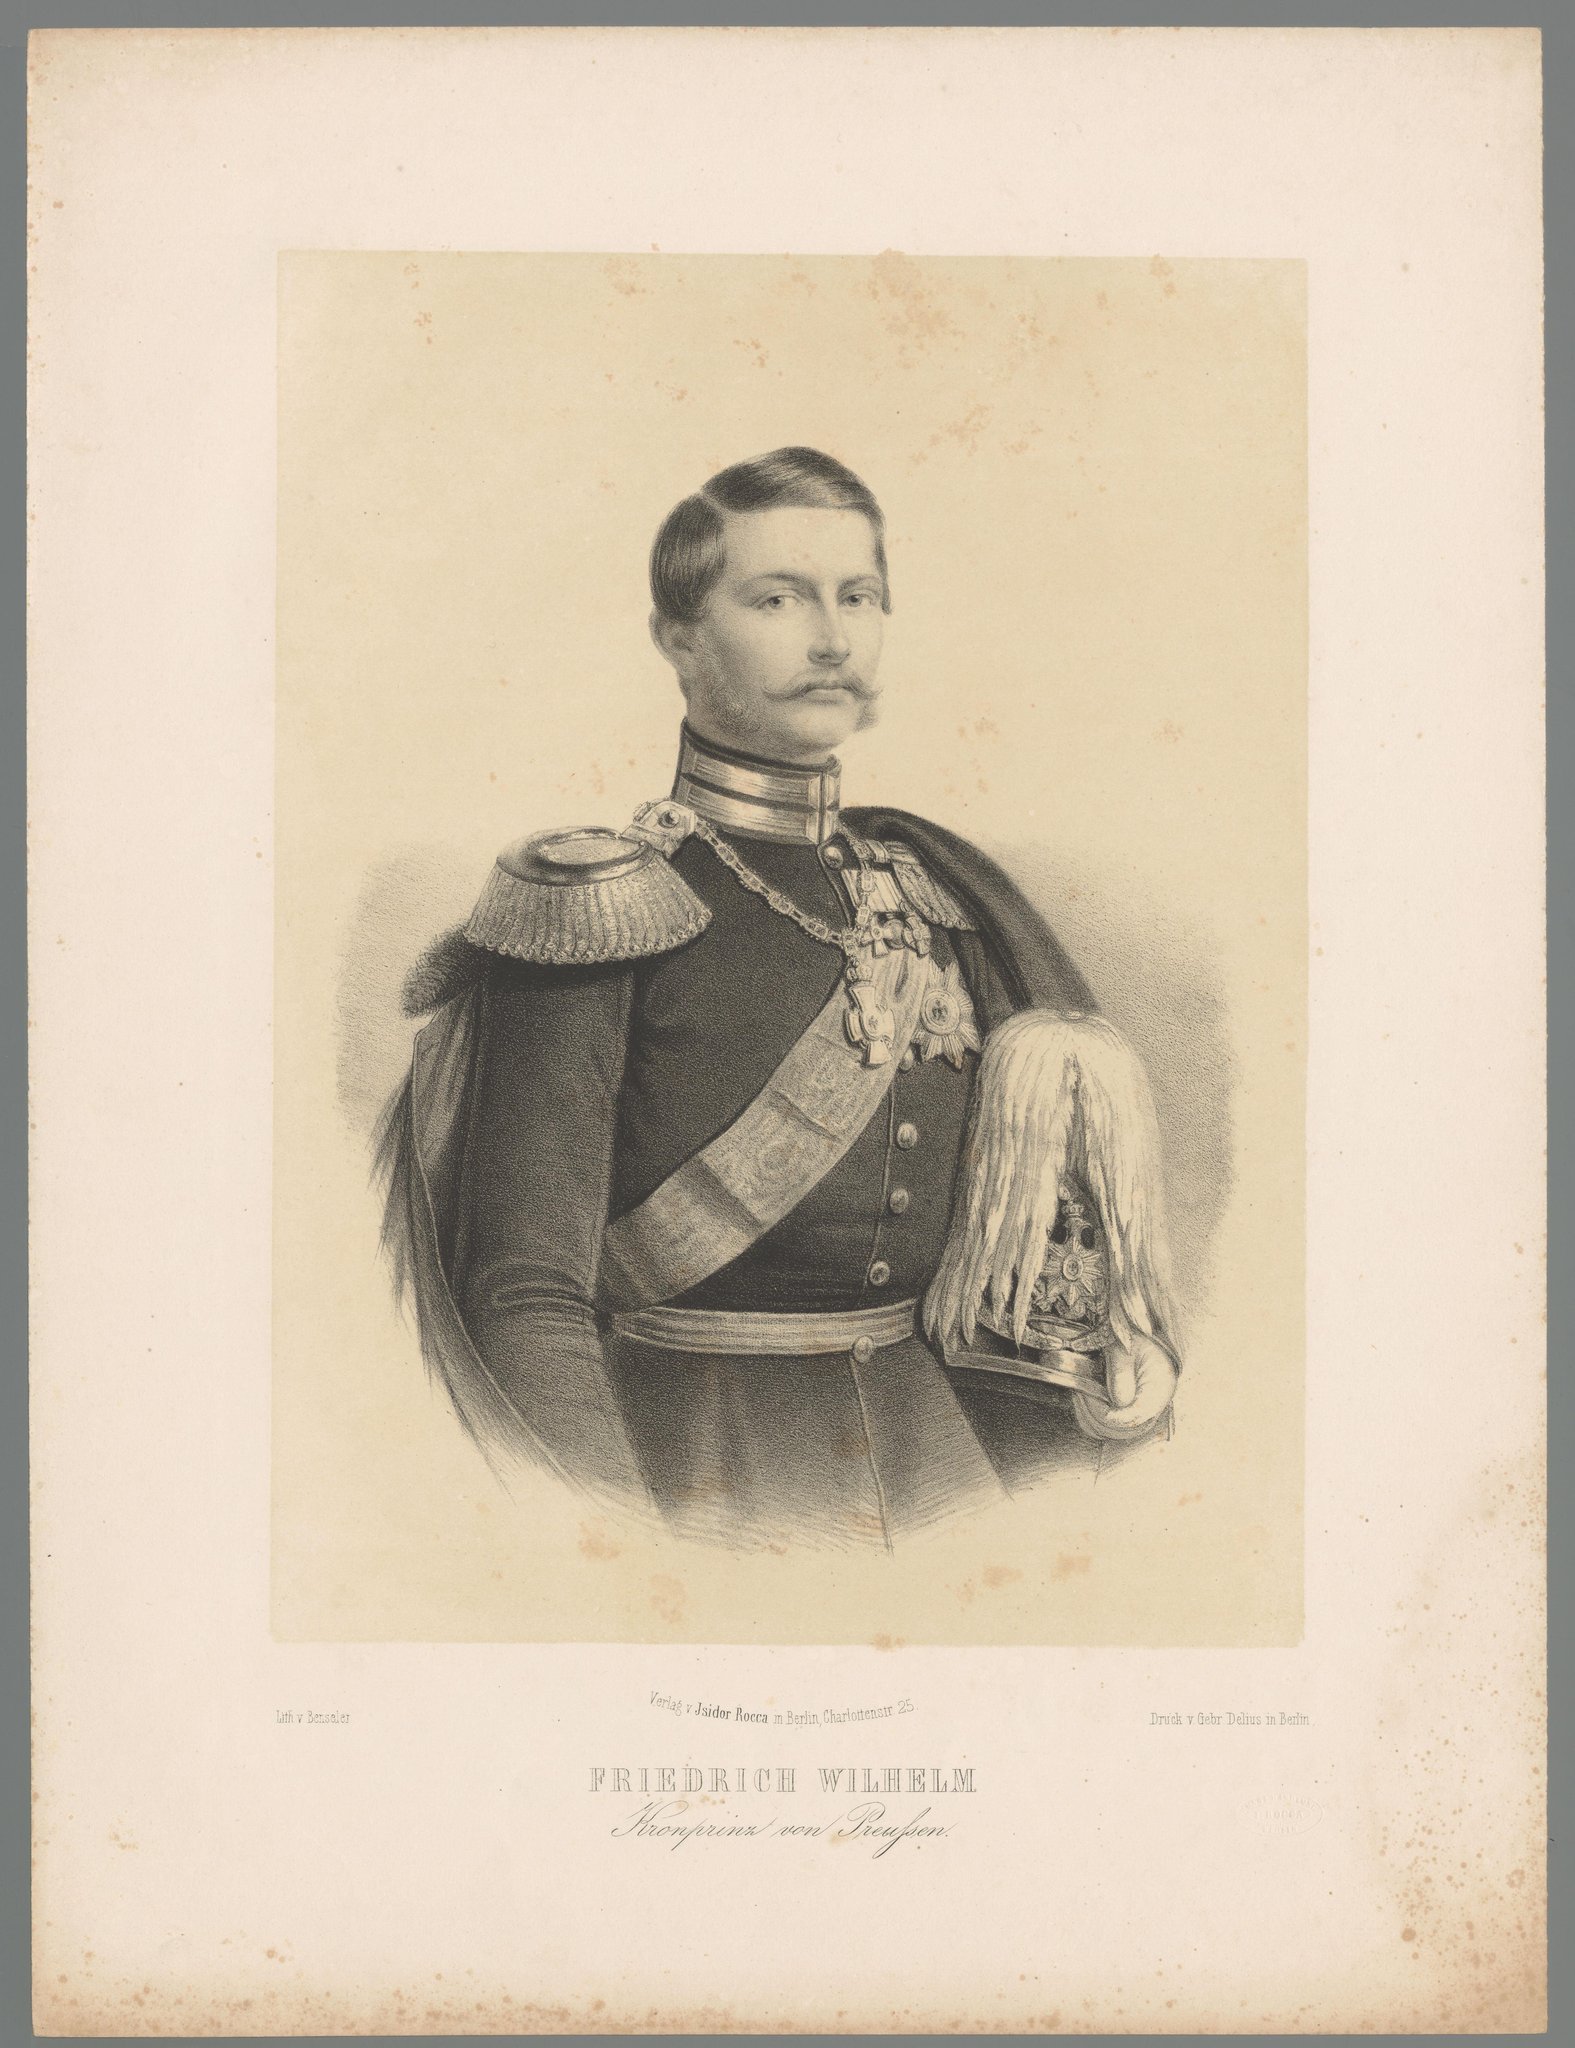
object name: print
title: Friedrich Wilhelm Kronprinz von Preussen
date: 1850-1899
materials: paper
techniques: tone lithography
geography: berlin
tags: moustache, adult man, historical persons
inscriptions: check stamp: ‘Kunsthandlung I. Rocca Berlin’, collector's mark: Lugt 2228